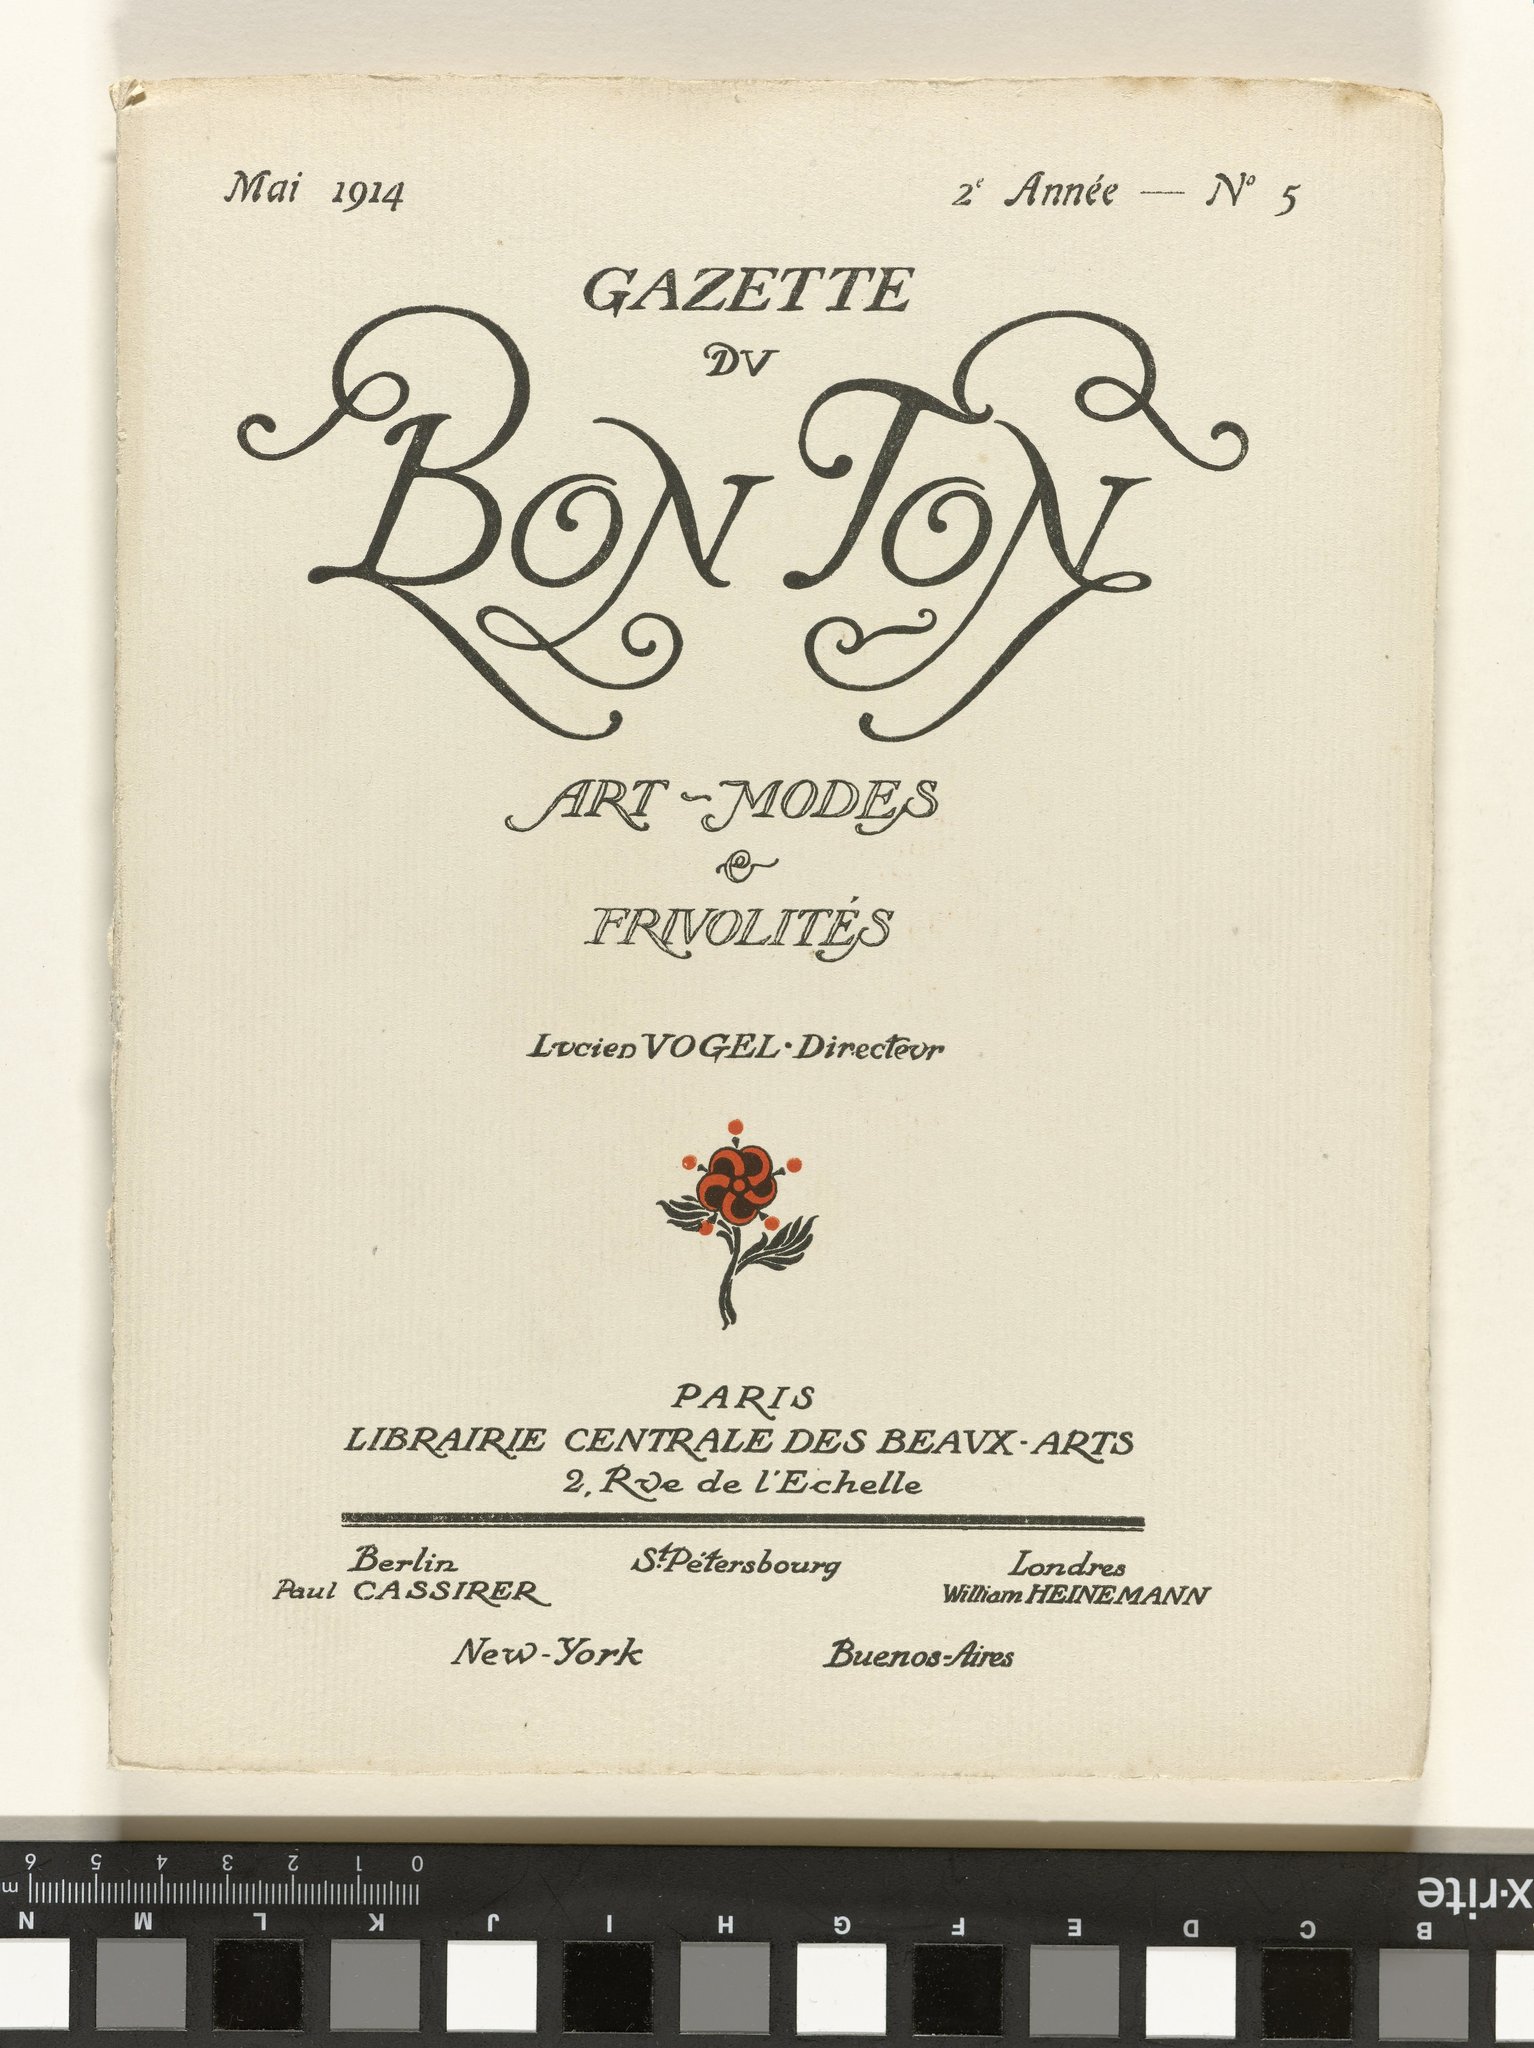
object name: fashion print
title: Gazette du Bon Ton. Art - Modes & Frivolités, 1914, 2e Année, No. 5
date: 1914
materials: paper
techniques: letterpress printing, pochoir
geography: berlin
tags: fashion plates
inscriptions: date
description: Aflevering no. 5, mei 1914, van Gazette du Bon Ton, bestaand uit een omslag, elf katernen met tekst en illustraties, en tien losse prenten. Aan dit deel werkten de volgende modeontwerpers mee: Cheruit, Doeuillet, Doucet, Lanvin, Poiret, Redfern en Worth.